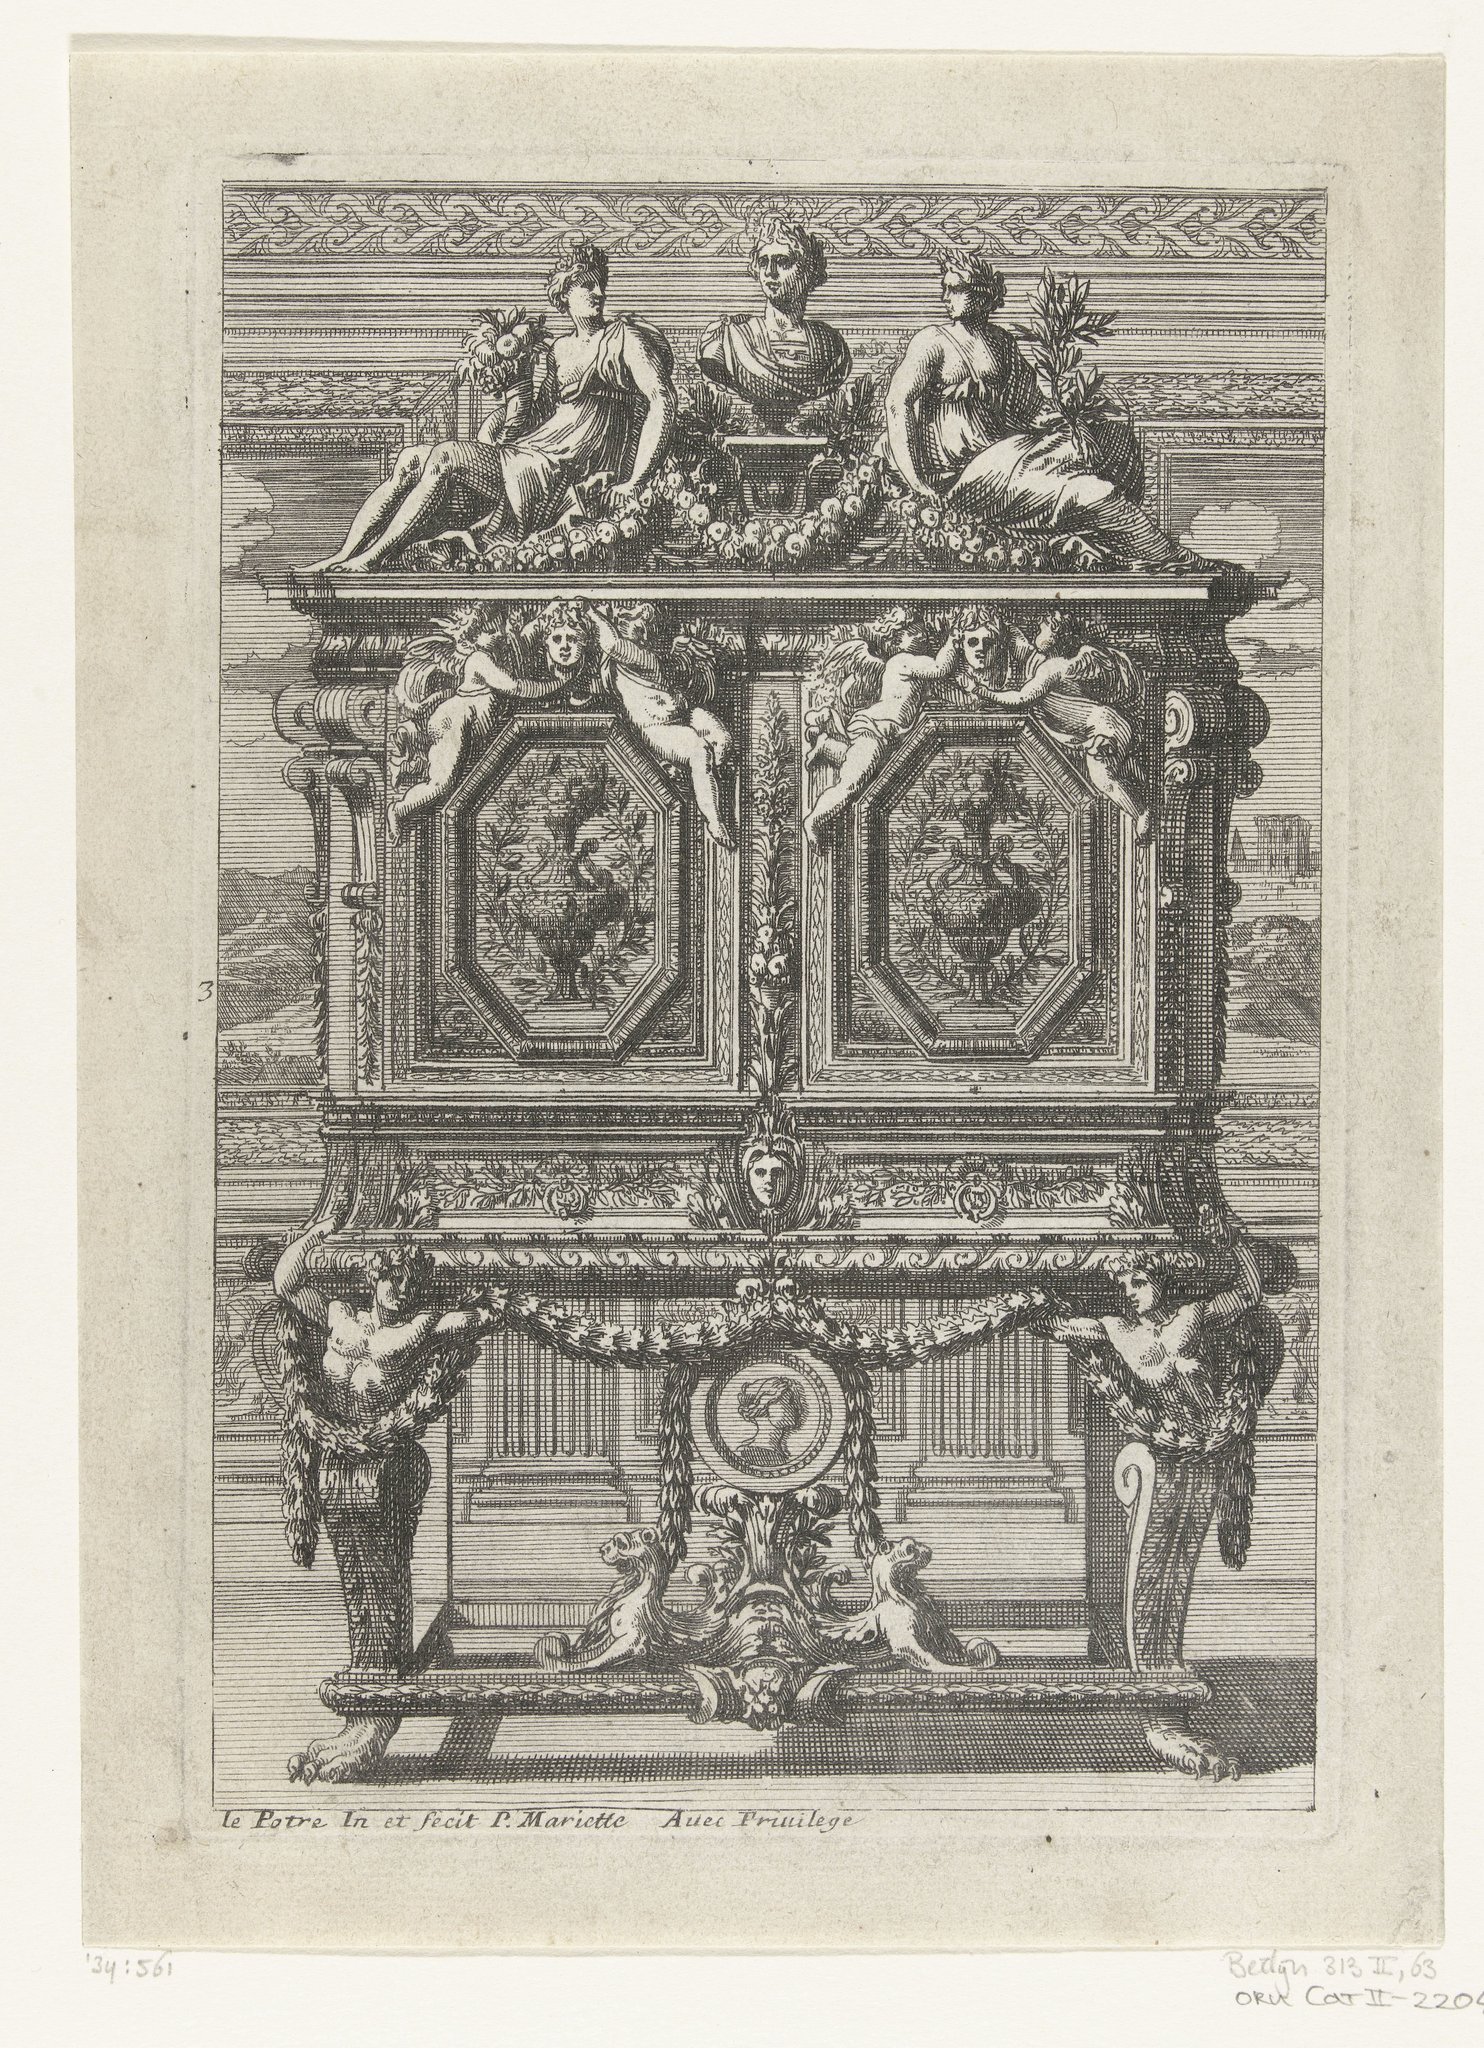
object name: print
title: Kabinet met twee deuren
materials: paper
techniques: etching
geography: france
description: De deuren zijn versierd met vazen in achthoekige panelen. Bovenaan staat een keizersbuste geflankeerd door twee vrouwen.